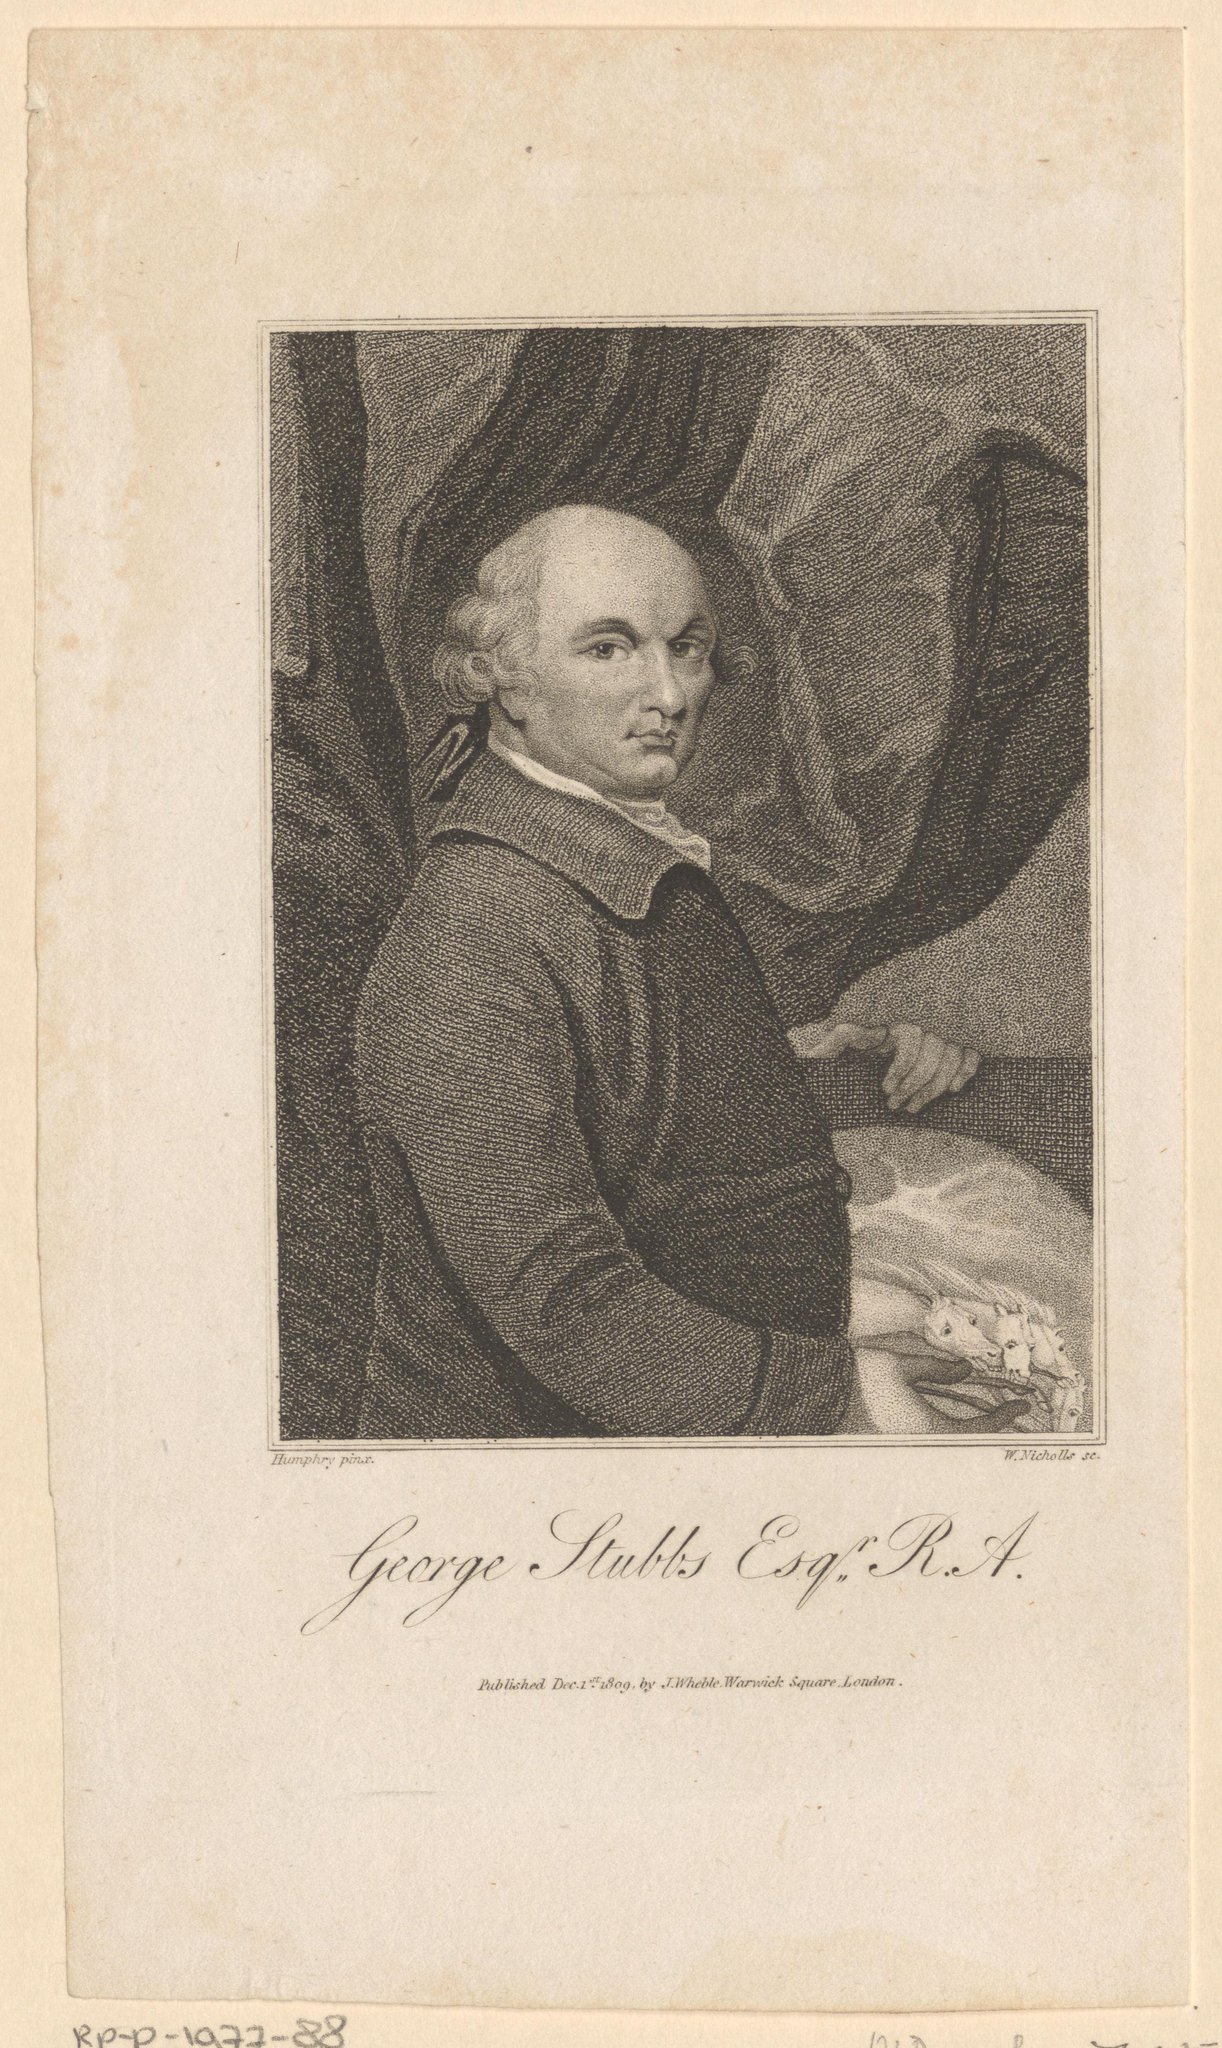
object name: print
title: Portret van George Stubbs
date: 1809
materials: paper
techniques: etching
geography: london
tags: liverpool, london, painter, print maker, george stubbs, historical persons, portrait, self-portrait of painter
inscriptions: collector's mark: Lugt 2228